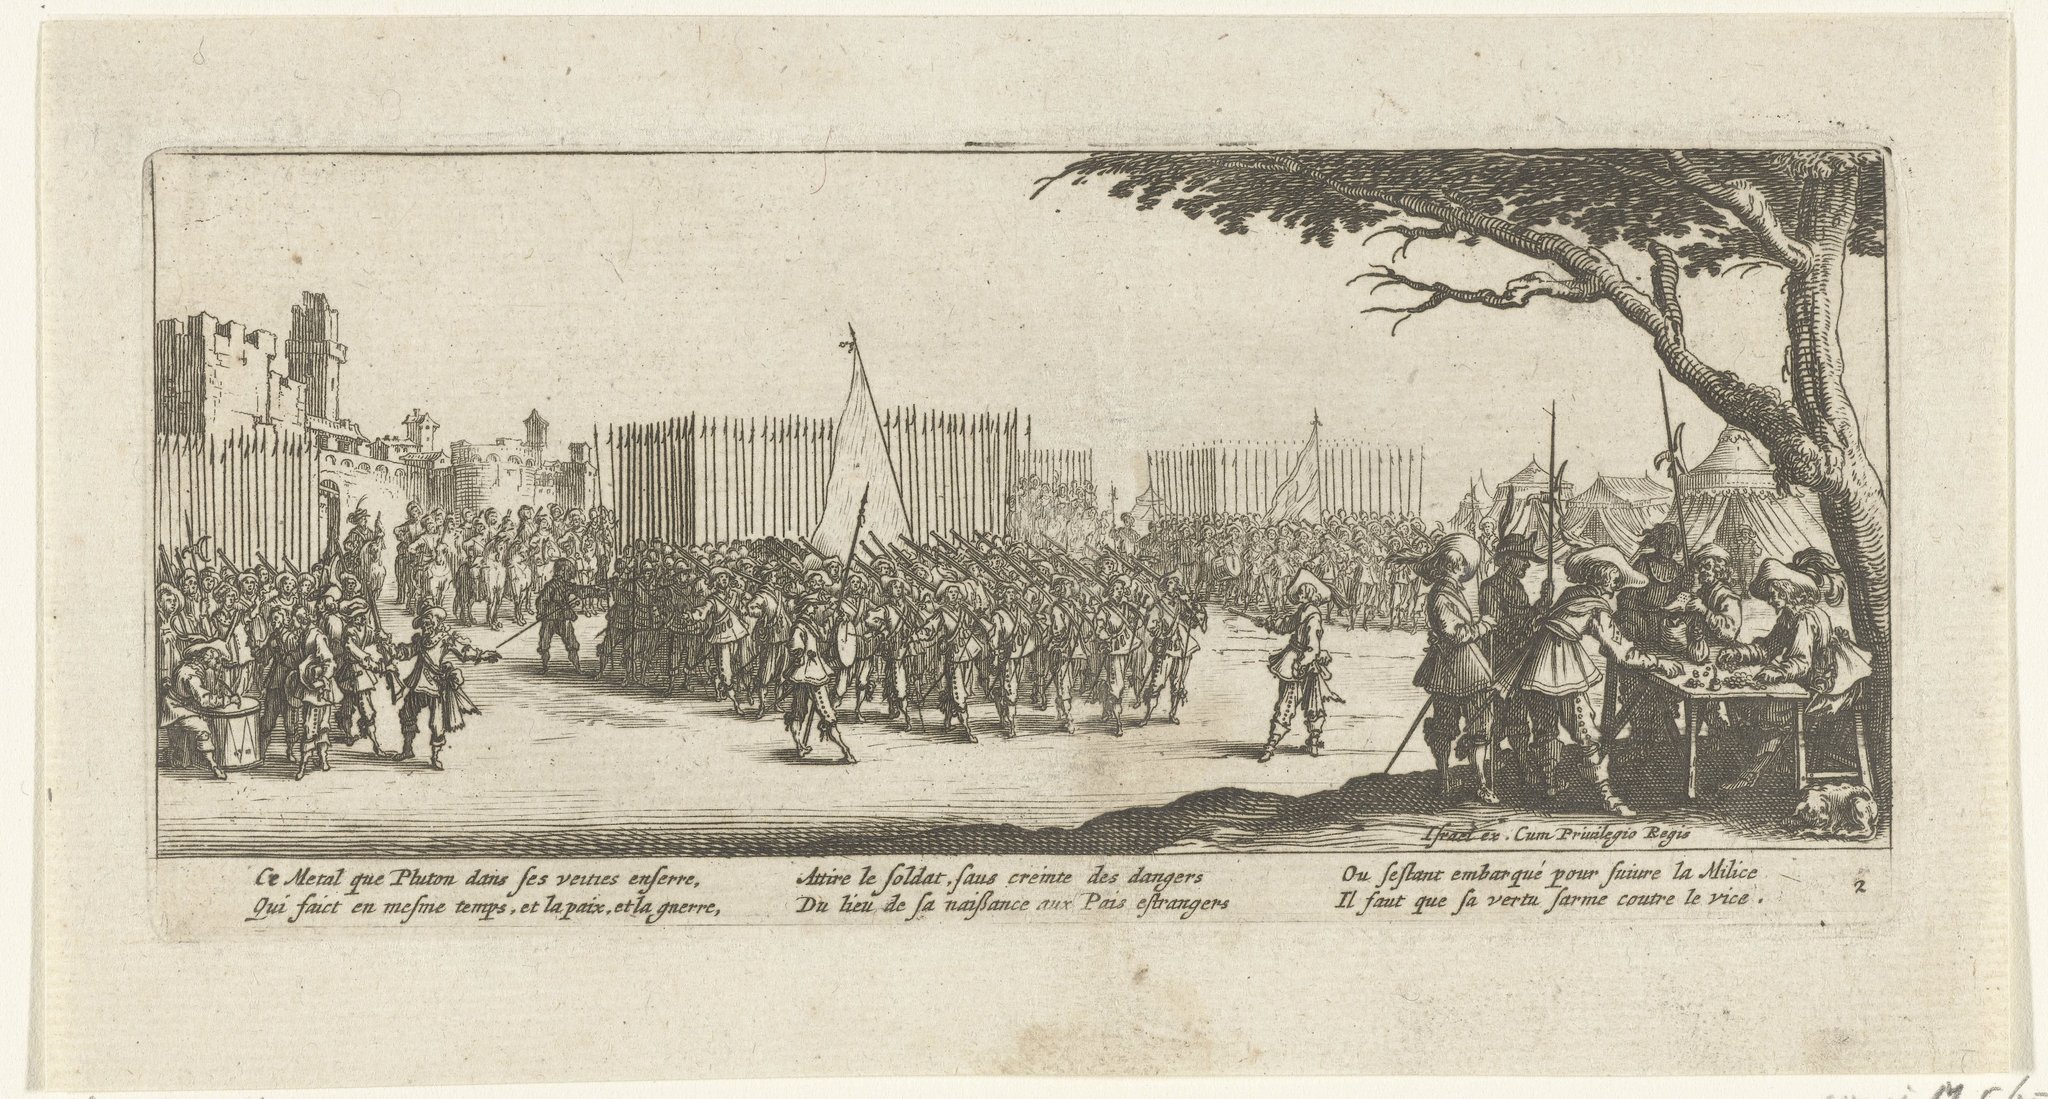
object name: print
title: De gruwelen van de oorlog (groot)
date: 1677-1690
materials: paper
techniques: etching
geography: amsterdam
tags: recruitment, military training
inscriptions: collector's mark: Lugt 2228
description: Links worden recruten ingeschreven en van een wapen voorzien. Rechts wordt hen een bedrag uitbetaald. In het midden en op de achtergrond is te zien hoe zij getraind worden. Links op de achtergrond de muren van een stad. Onder de voorstelling een zesregelig Frans vers. Deze prent is onderdeel van een serie van 17 (18 incl. titelprent) prenten met voorstellingen van diverse soorten ellende die oorlogvoering met zich meebrengt.